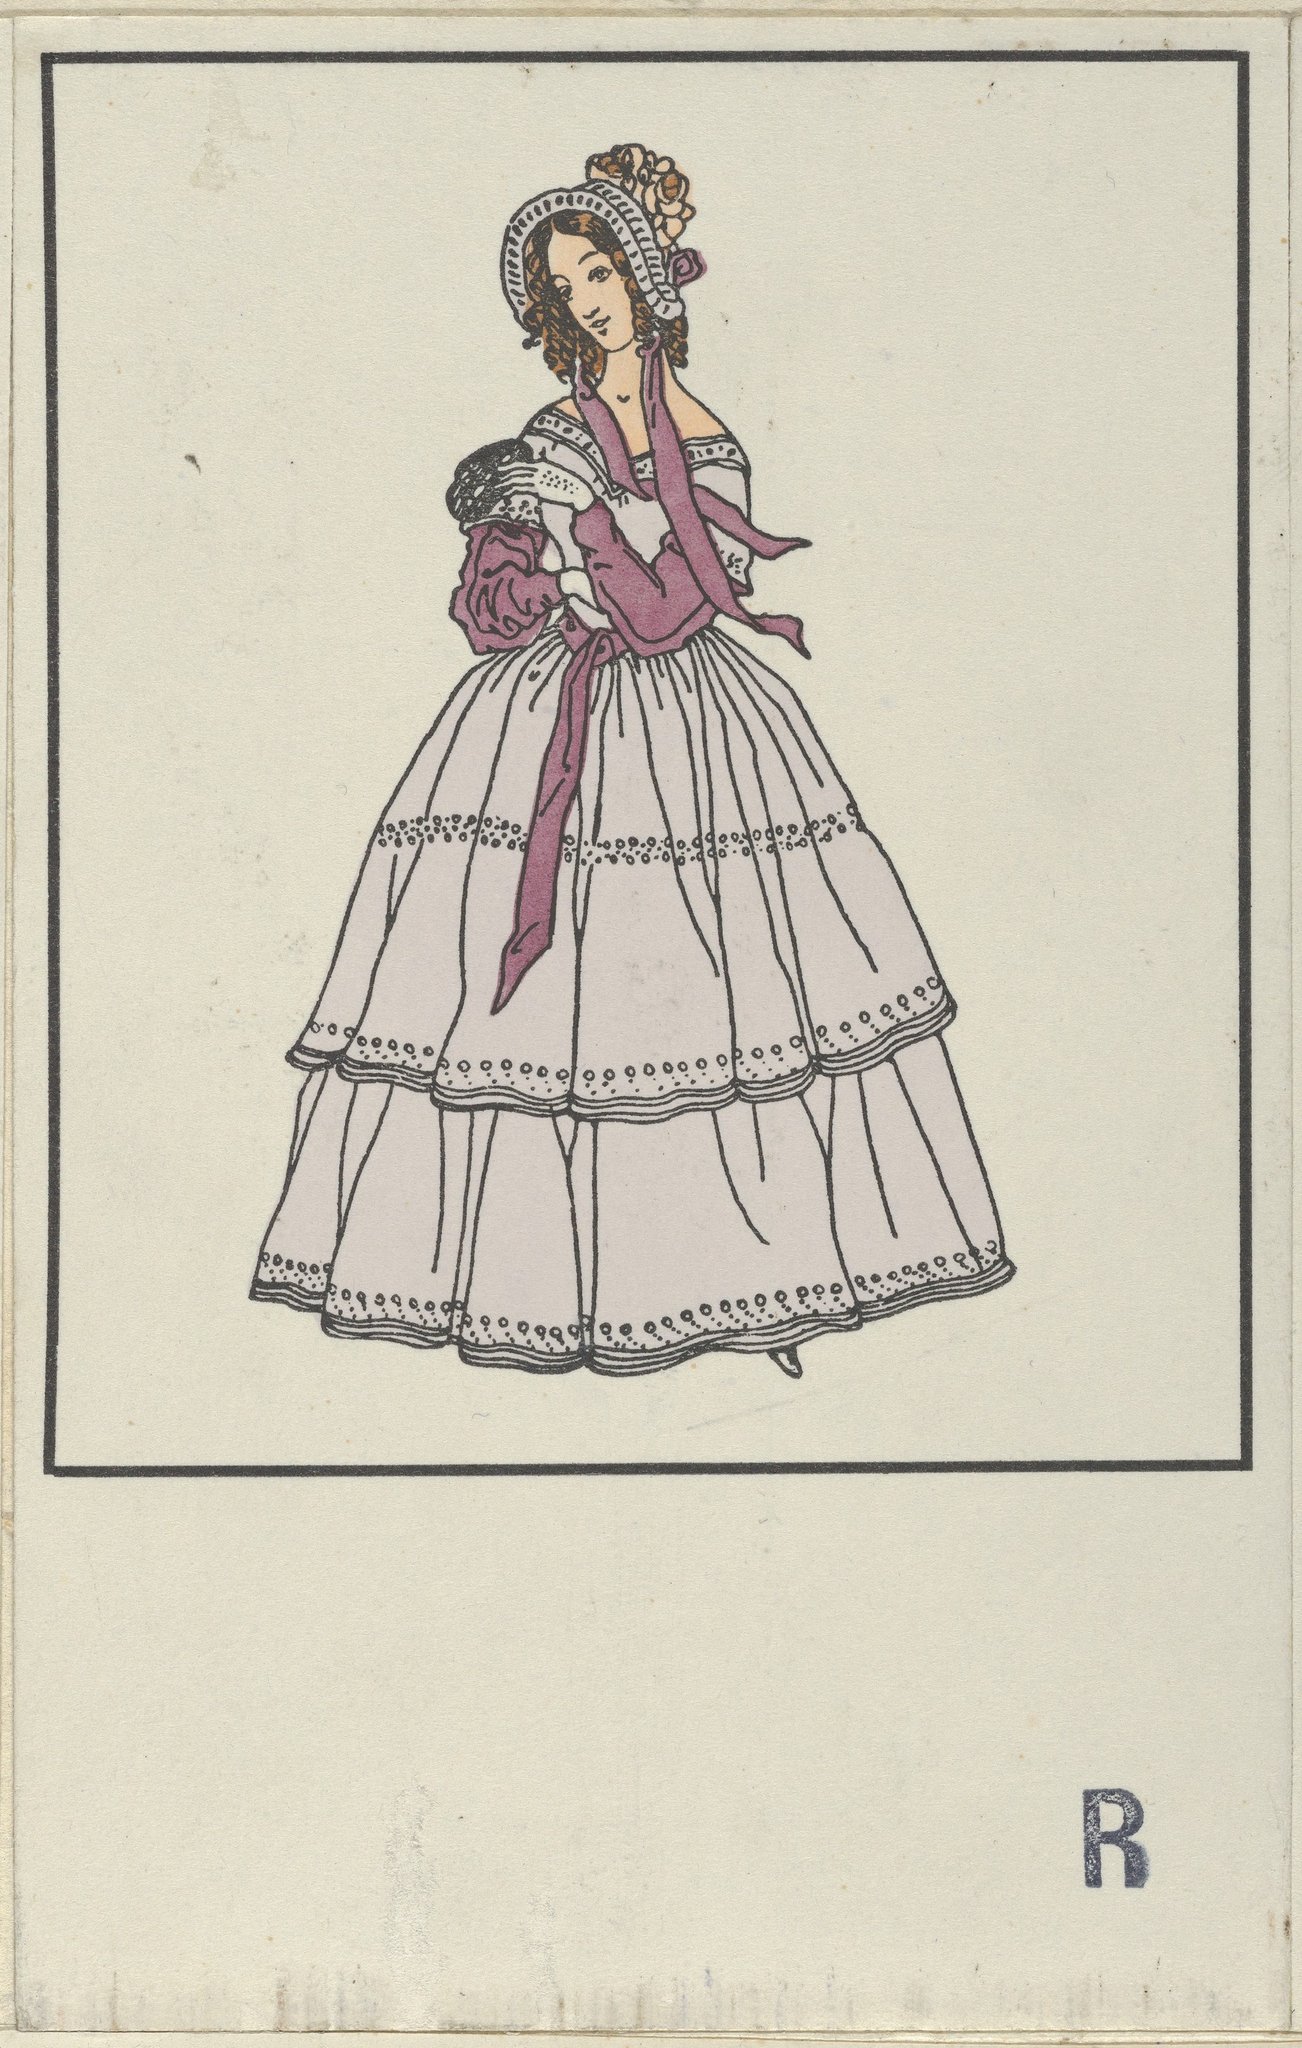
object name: print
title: Biedermeier Fashion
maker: urban janke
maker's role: artist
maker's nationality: austrian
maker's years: 1887-1914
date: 1908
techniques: lithograph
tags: women,fashion